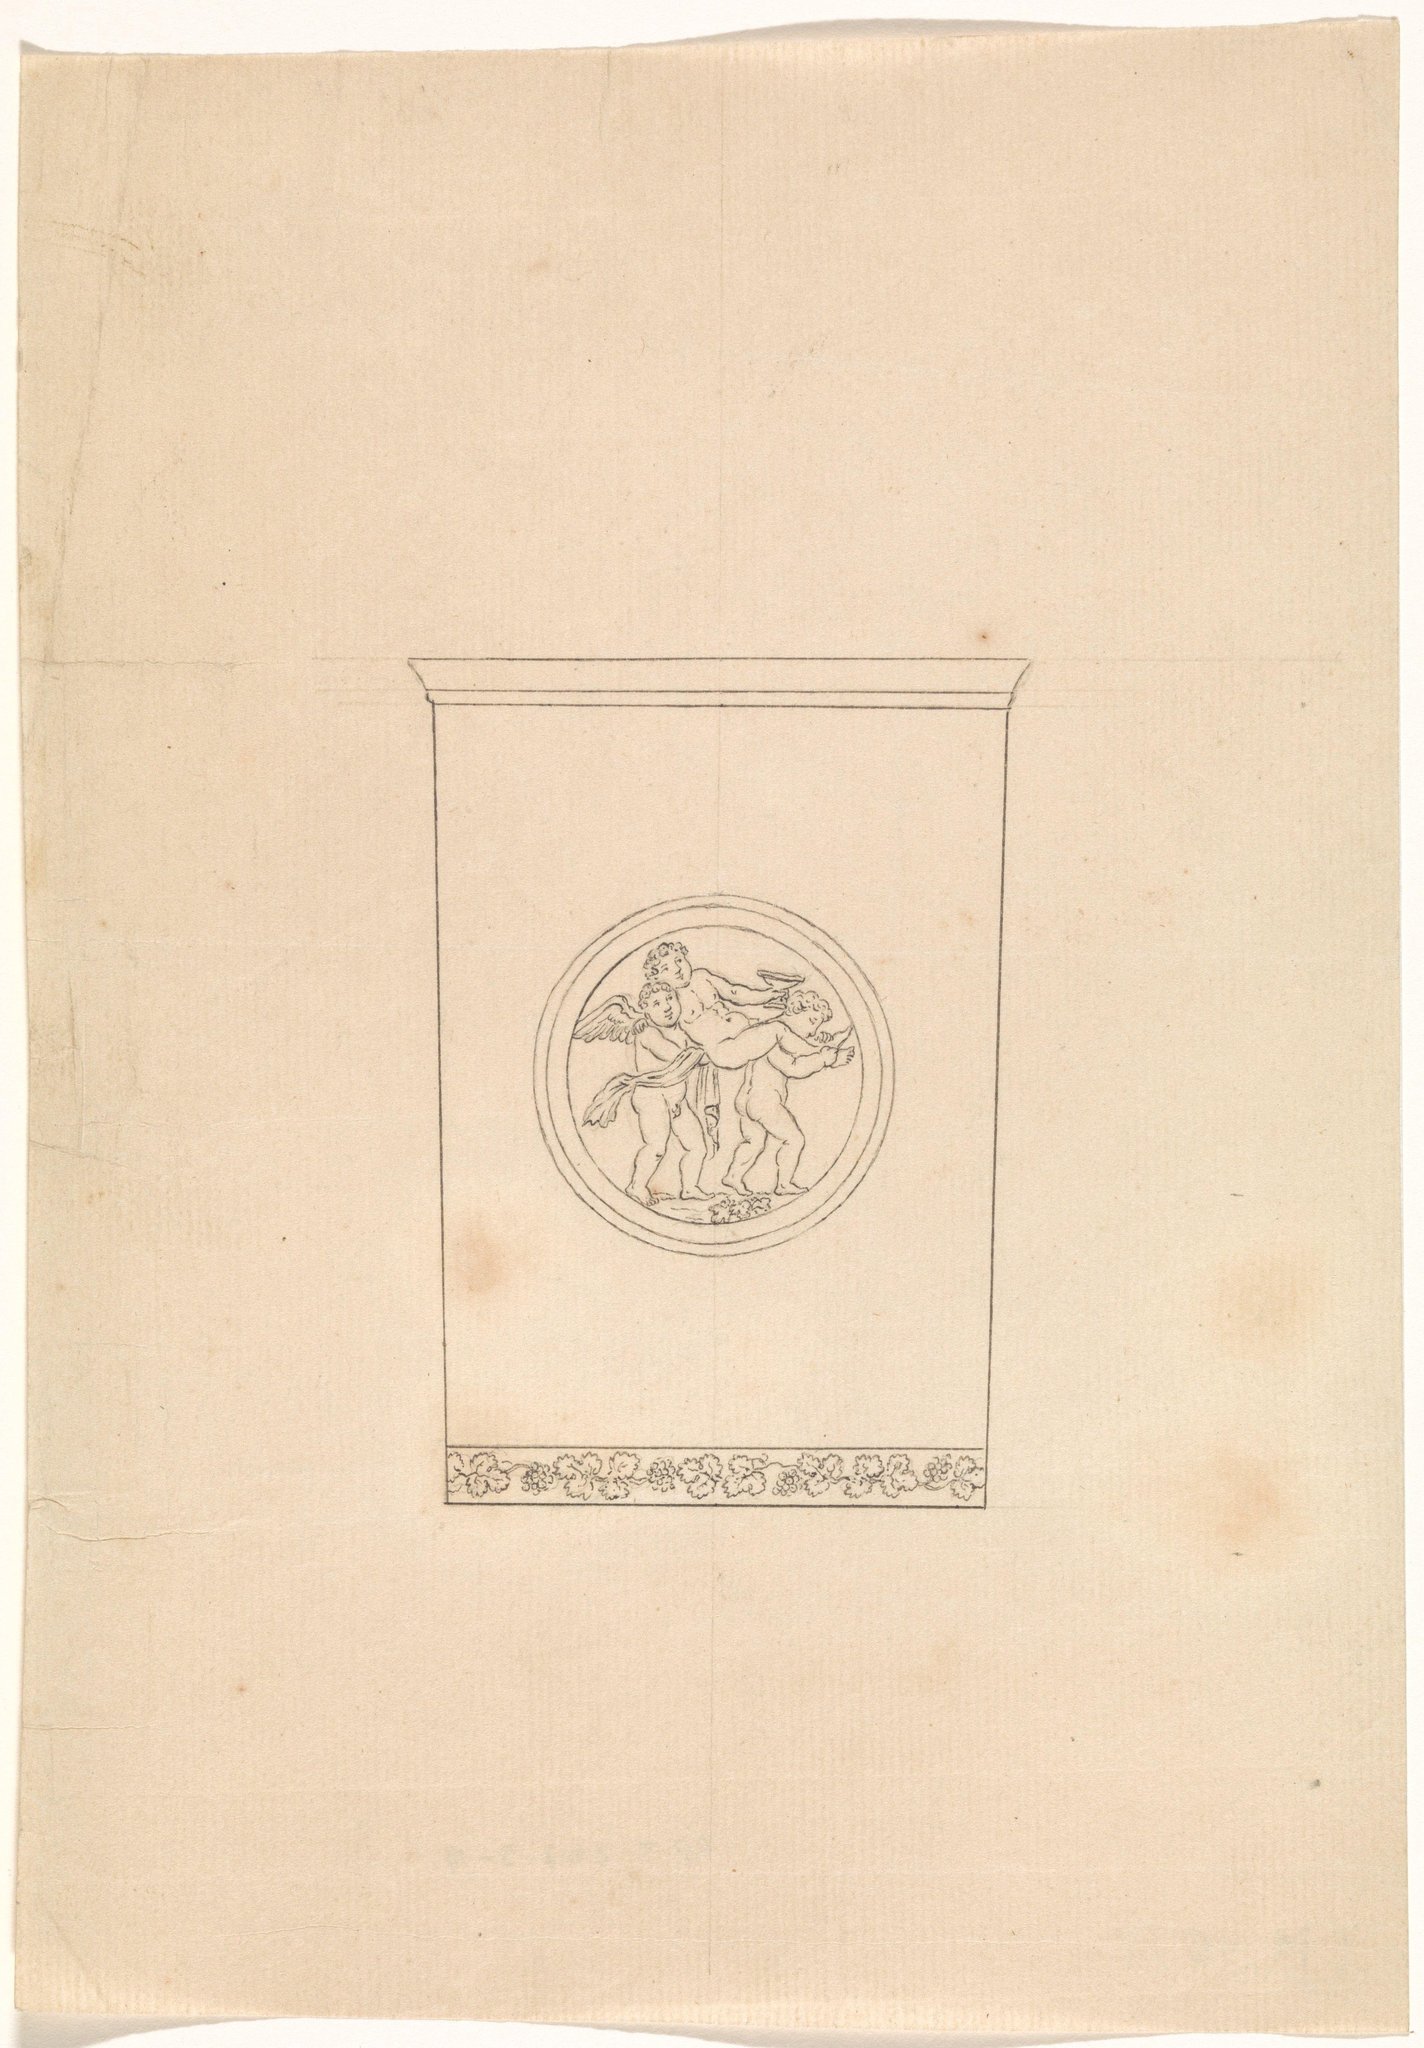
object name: drawing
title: Beker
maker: Anonymous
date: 1800-1820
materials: paper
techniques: pen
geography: germany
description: Ronde beker met gegraveerde decoratie van een medaillon met naakte jongetjes en een putto en een rand van druivenranken.